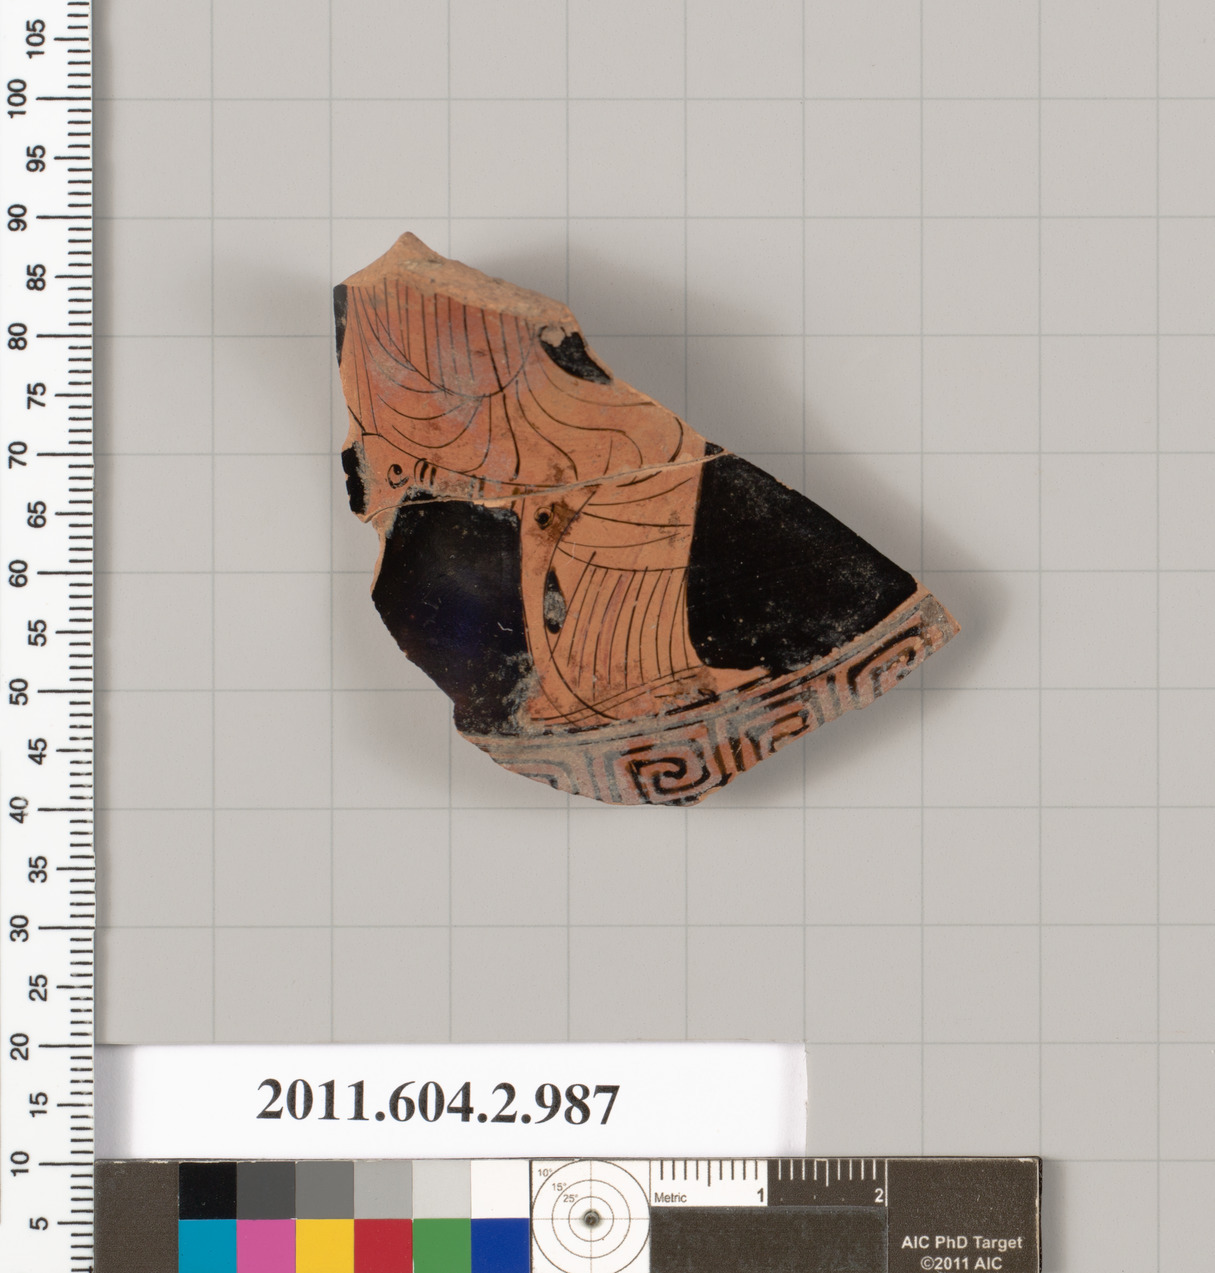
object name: oinochoe fragment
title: Terracotta fragment of an oinochoe (jug)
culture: greek, attic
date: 460-440 BCE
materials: terracotta